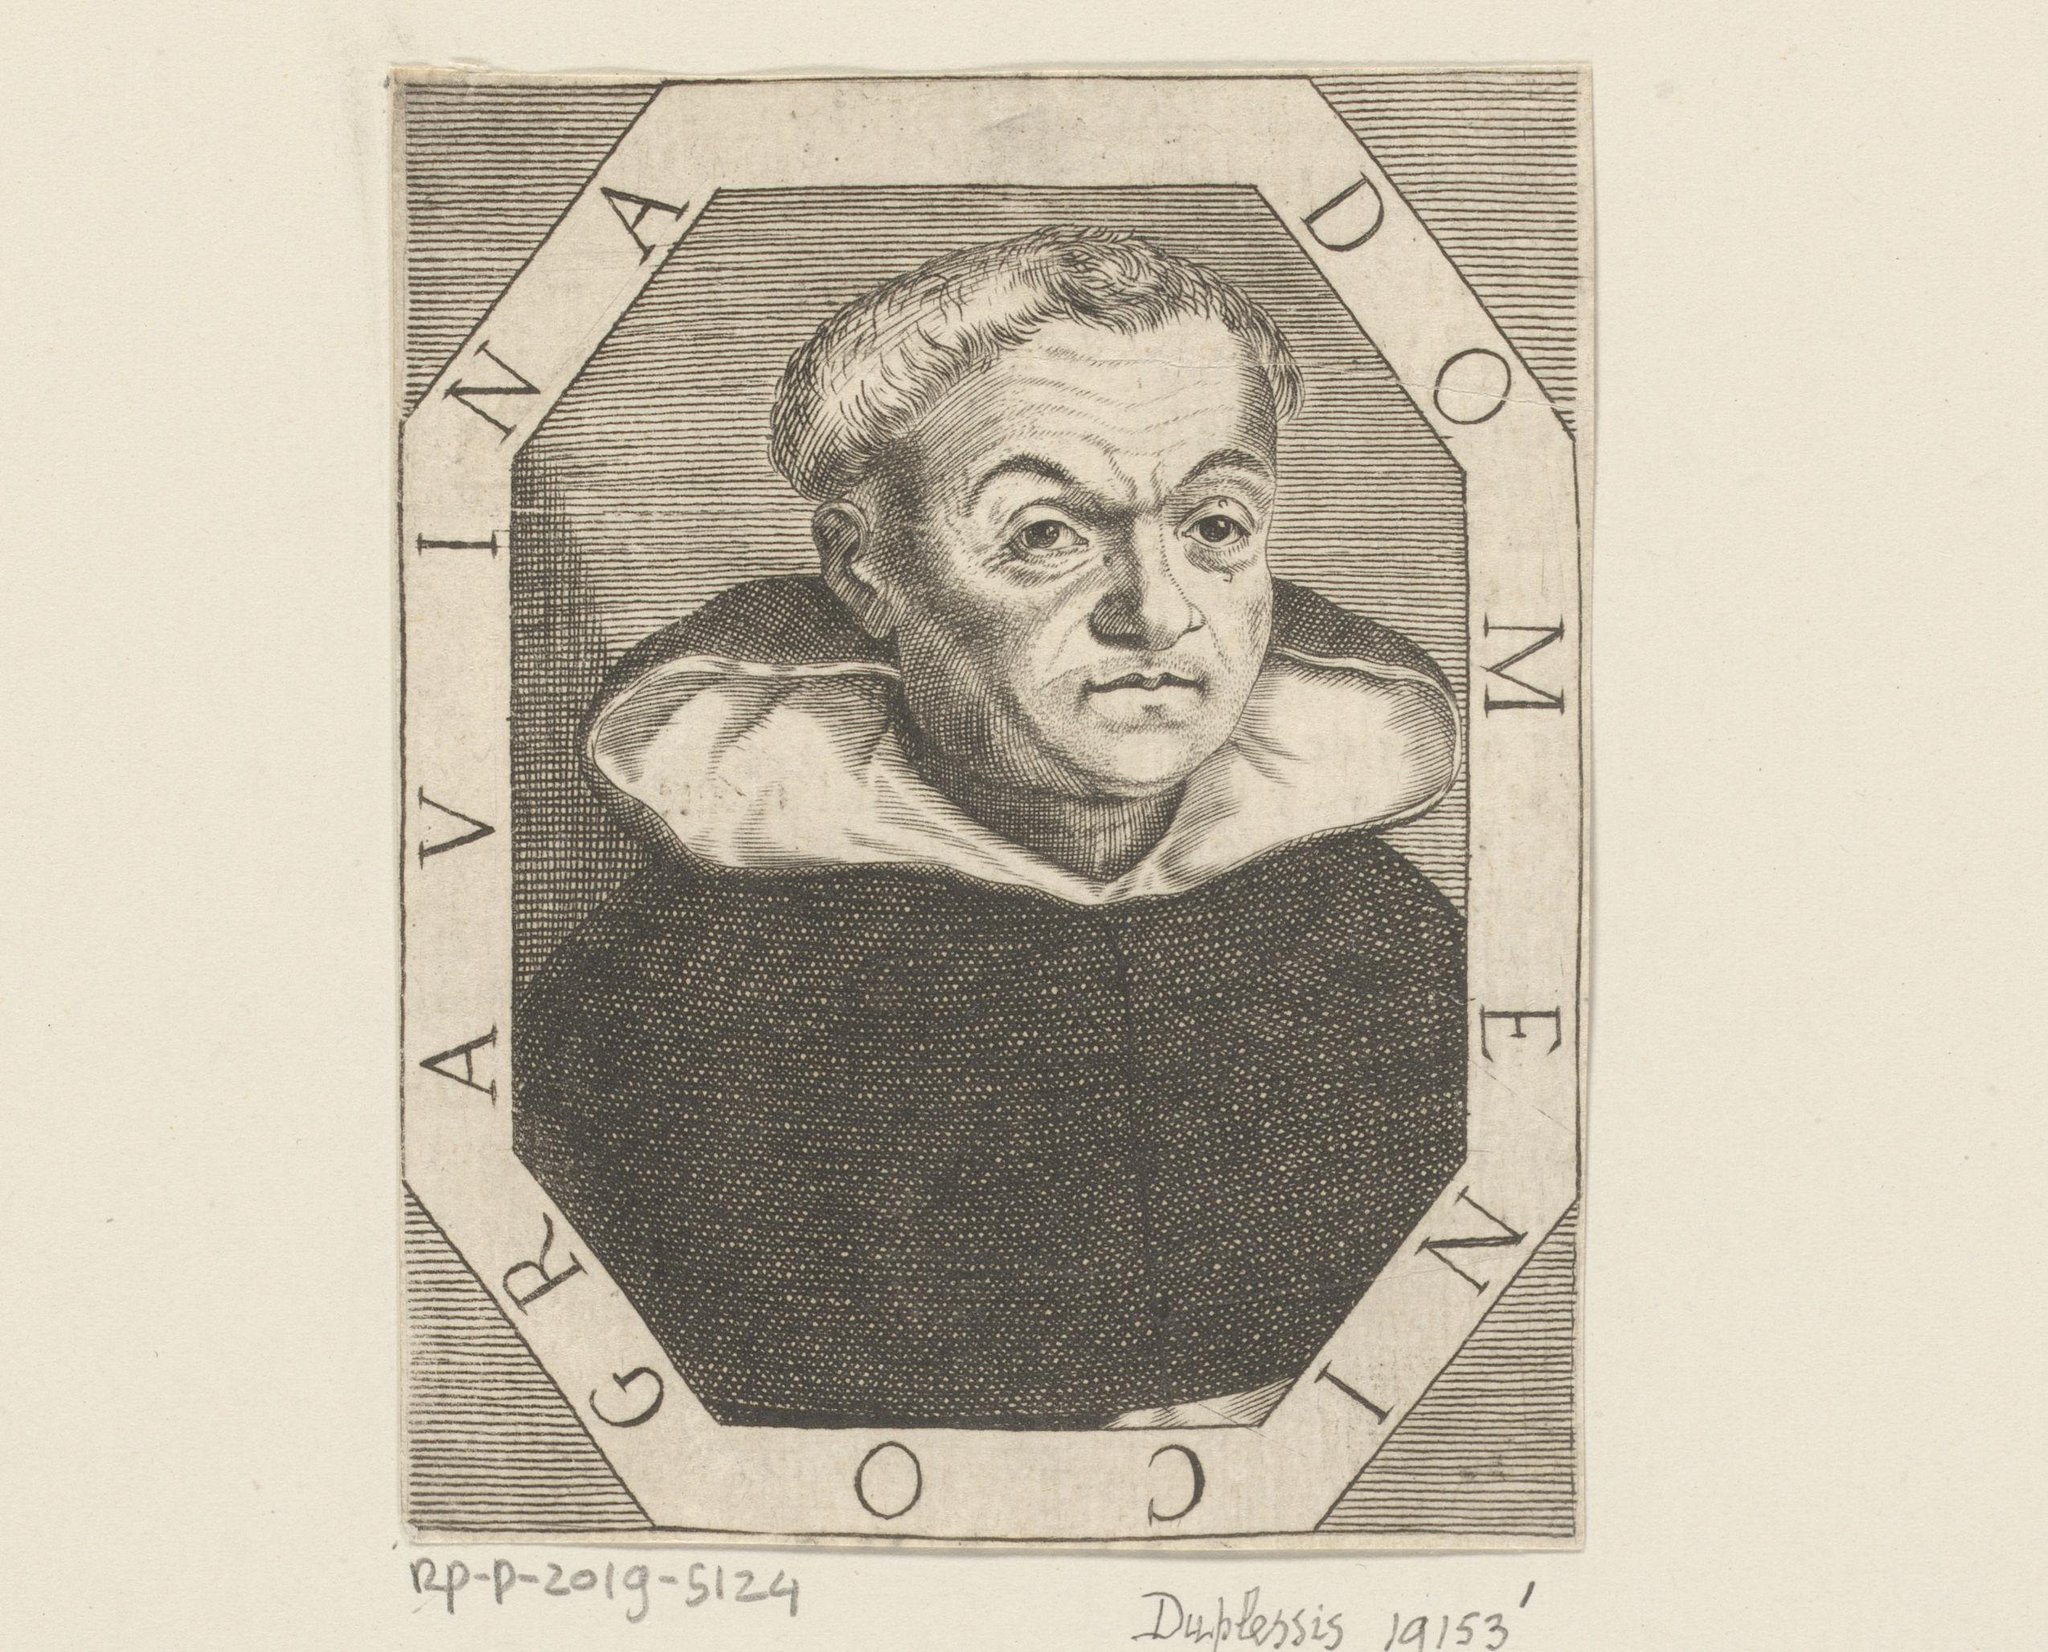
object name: print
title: Portret van theoloog Domenico Gravina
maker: Anonymous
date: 1666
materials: paper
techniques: engraving, letterpress printing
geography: venice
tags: rome, historical persons, portrait of a writer, writer, poet, author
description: Prent uit: Crasso, Lorenzo. Elogii degli huomini letterati scritti. Venetië: Combi & la Noù, 1666, dl. 2, p. 166.